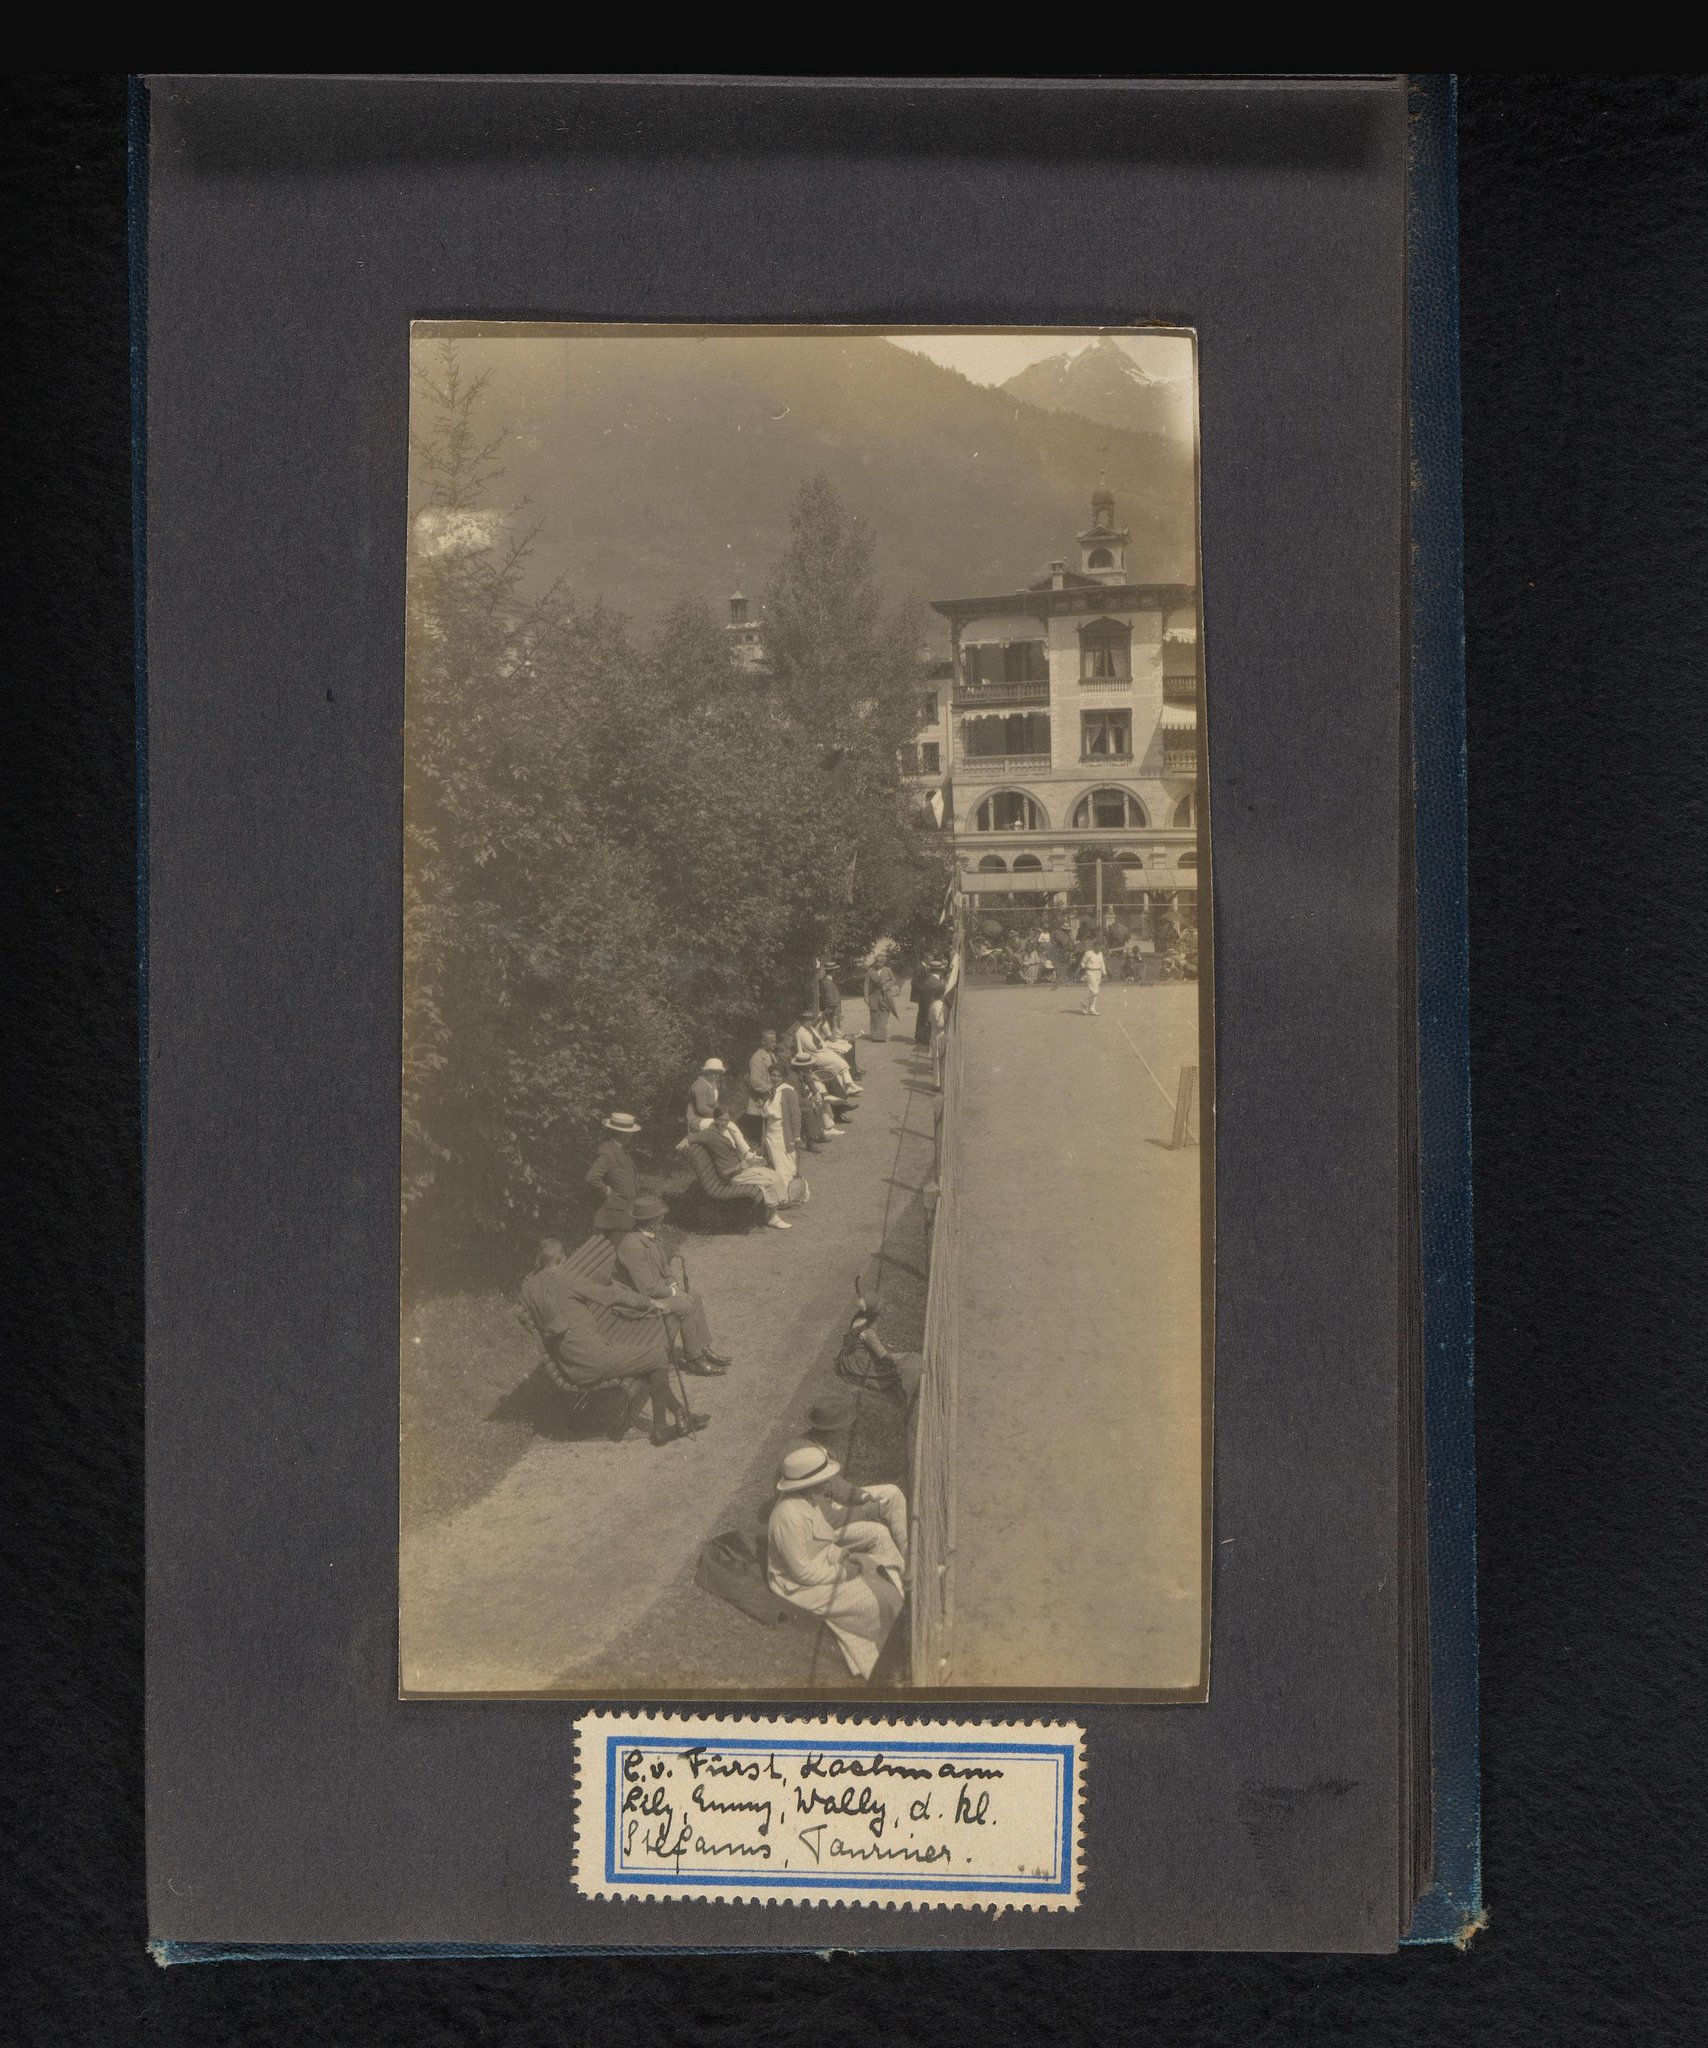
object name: photograph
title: Tennistoernooi 1913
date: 1913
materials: paper, photographic support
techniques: gelatin silver print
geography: switzerland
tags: else wachenheimer-moos, tennis, lawn-tennis, switzerland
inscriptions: inscription: ‘Tennis Tournier 1913 Fran ... Sohn ... / Fran Stefanus u. Sohn, Waldhaus’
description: Albumblad met een foto van een tenniswedstrijd tijdens een toernooi in 1913 in Waldhaus, Zwitserland. Onderdeel van het fotoalbum van Else Wachenheimer-Moos en haar broers Arthur en Willy Moos en anderen in de periode 1913-1918.